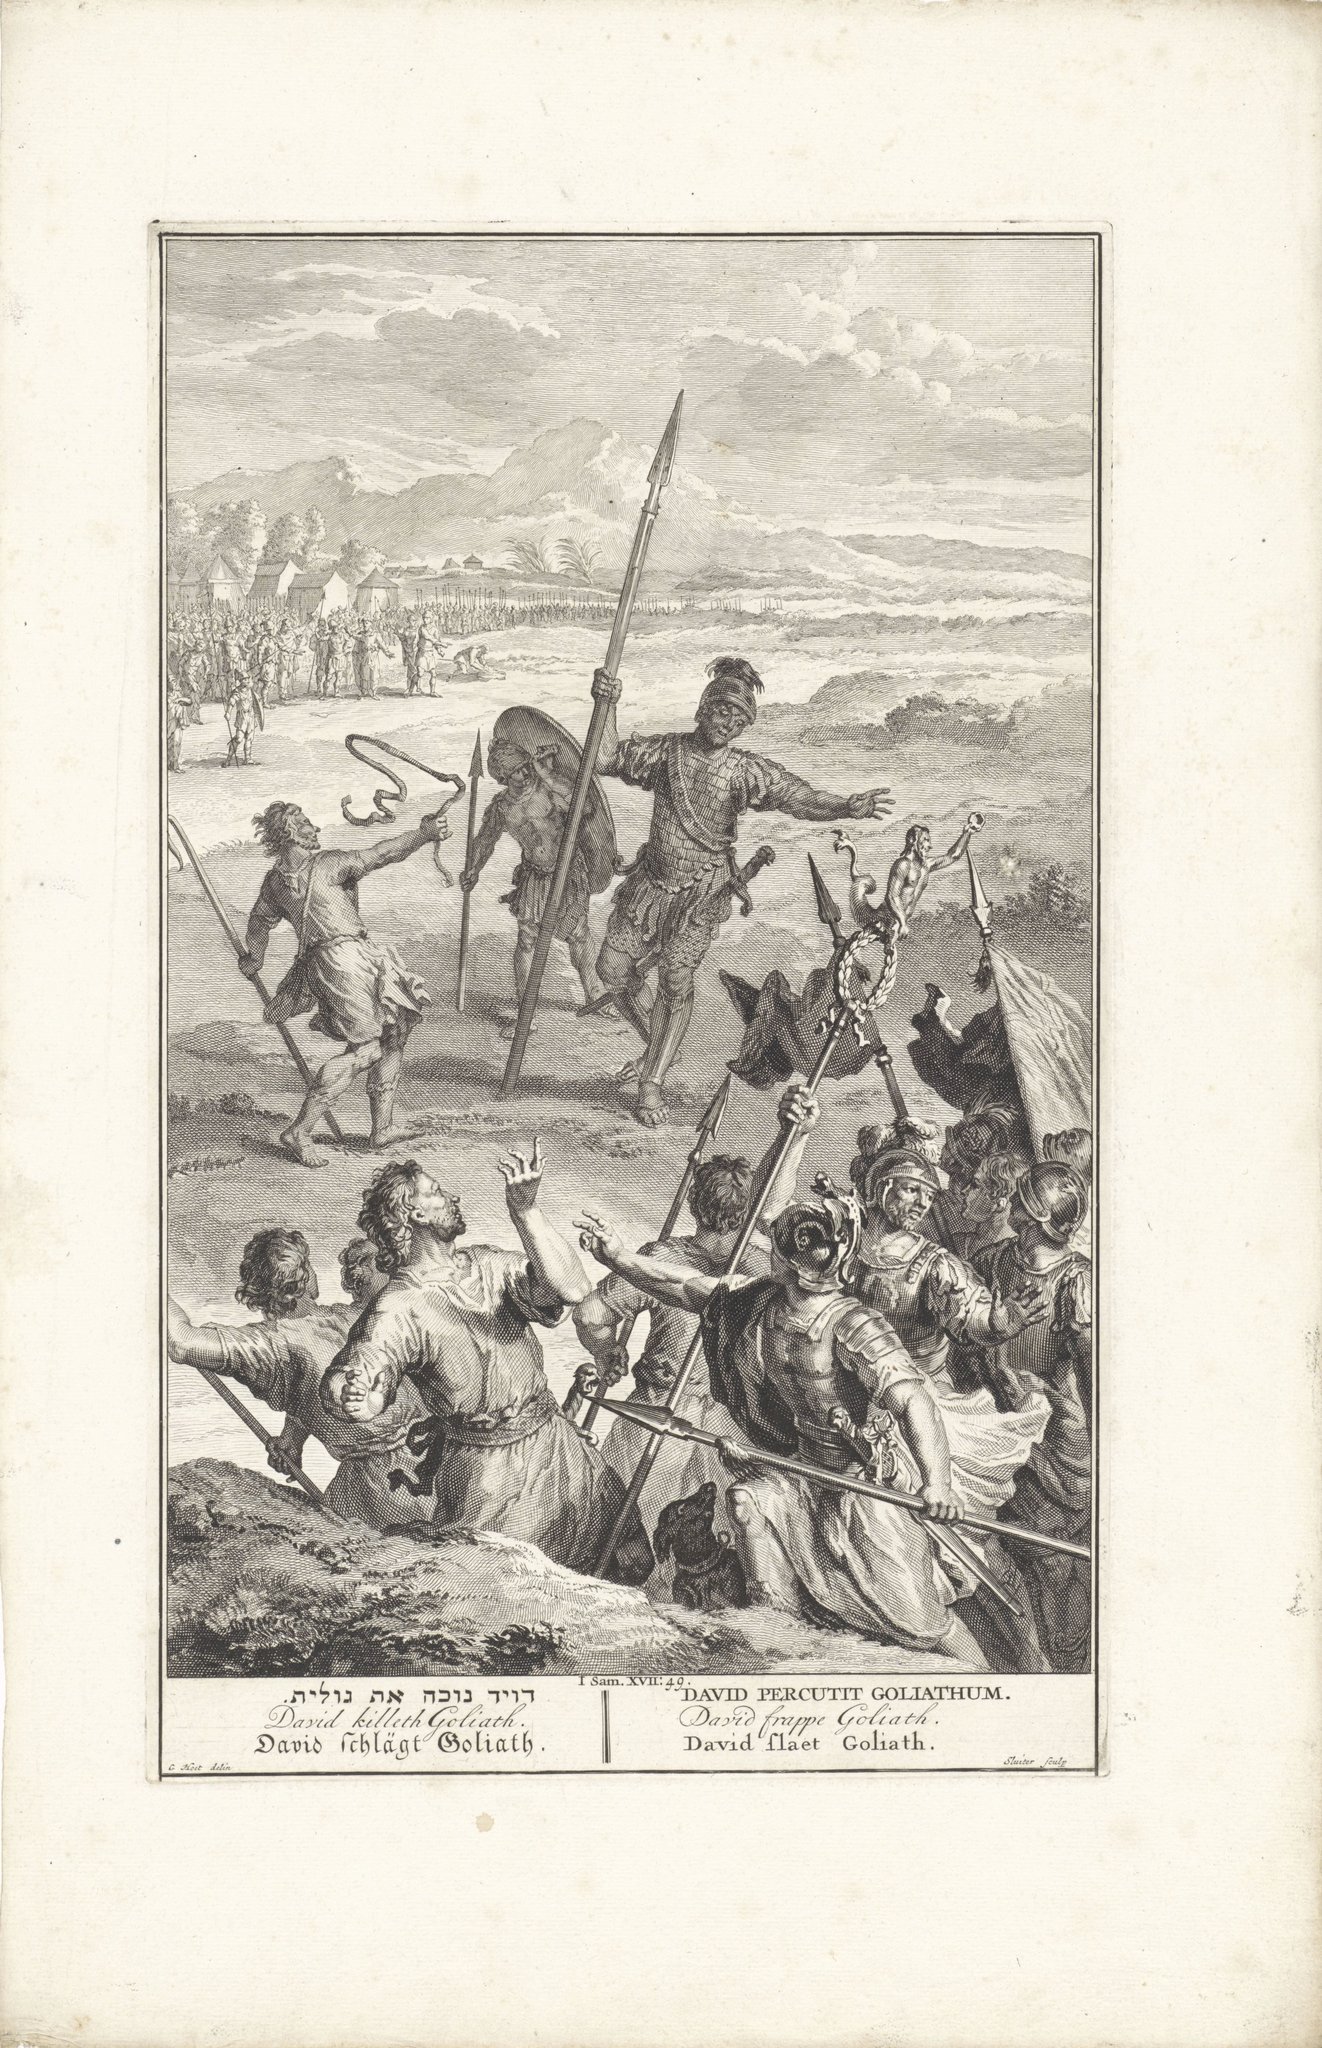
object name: book illustration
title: David verslaat Goliath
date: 1705-1720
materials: paper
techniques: engraving, etching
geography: amsterdam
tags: david slings a stone at goliath's forehead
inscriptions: collector's mark: ‘Utrechts Fundatie huijs’, collector's mark: Lugt 2228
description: Prent oorspronkelijk bedoeld voor: Figures de la Bible. Amsterdam: Bernard Picart, 1720. Prent ook gebruikt in: Taferelen der voornaamste geschiedenissen van het Oude en Nieuwe Testament (...) door de vermaarde kunstenaars Hoet, Houbraken, en Picart getekent (...) en met beschrijvingen uitgebreid. Den Haag: Pieter de Hondt, 1728.